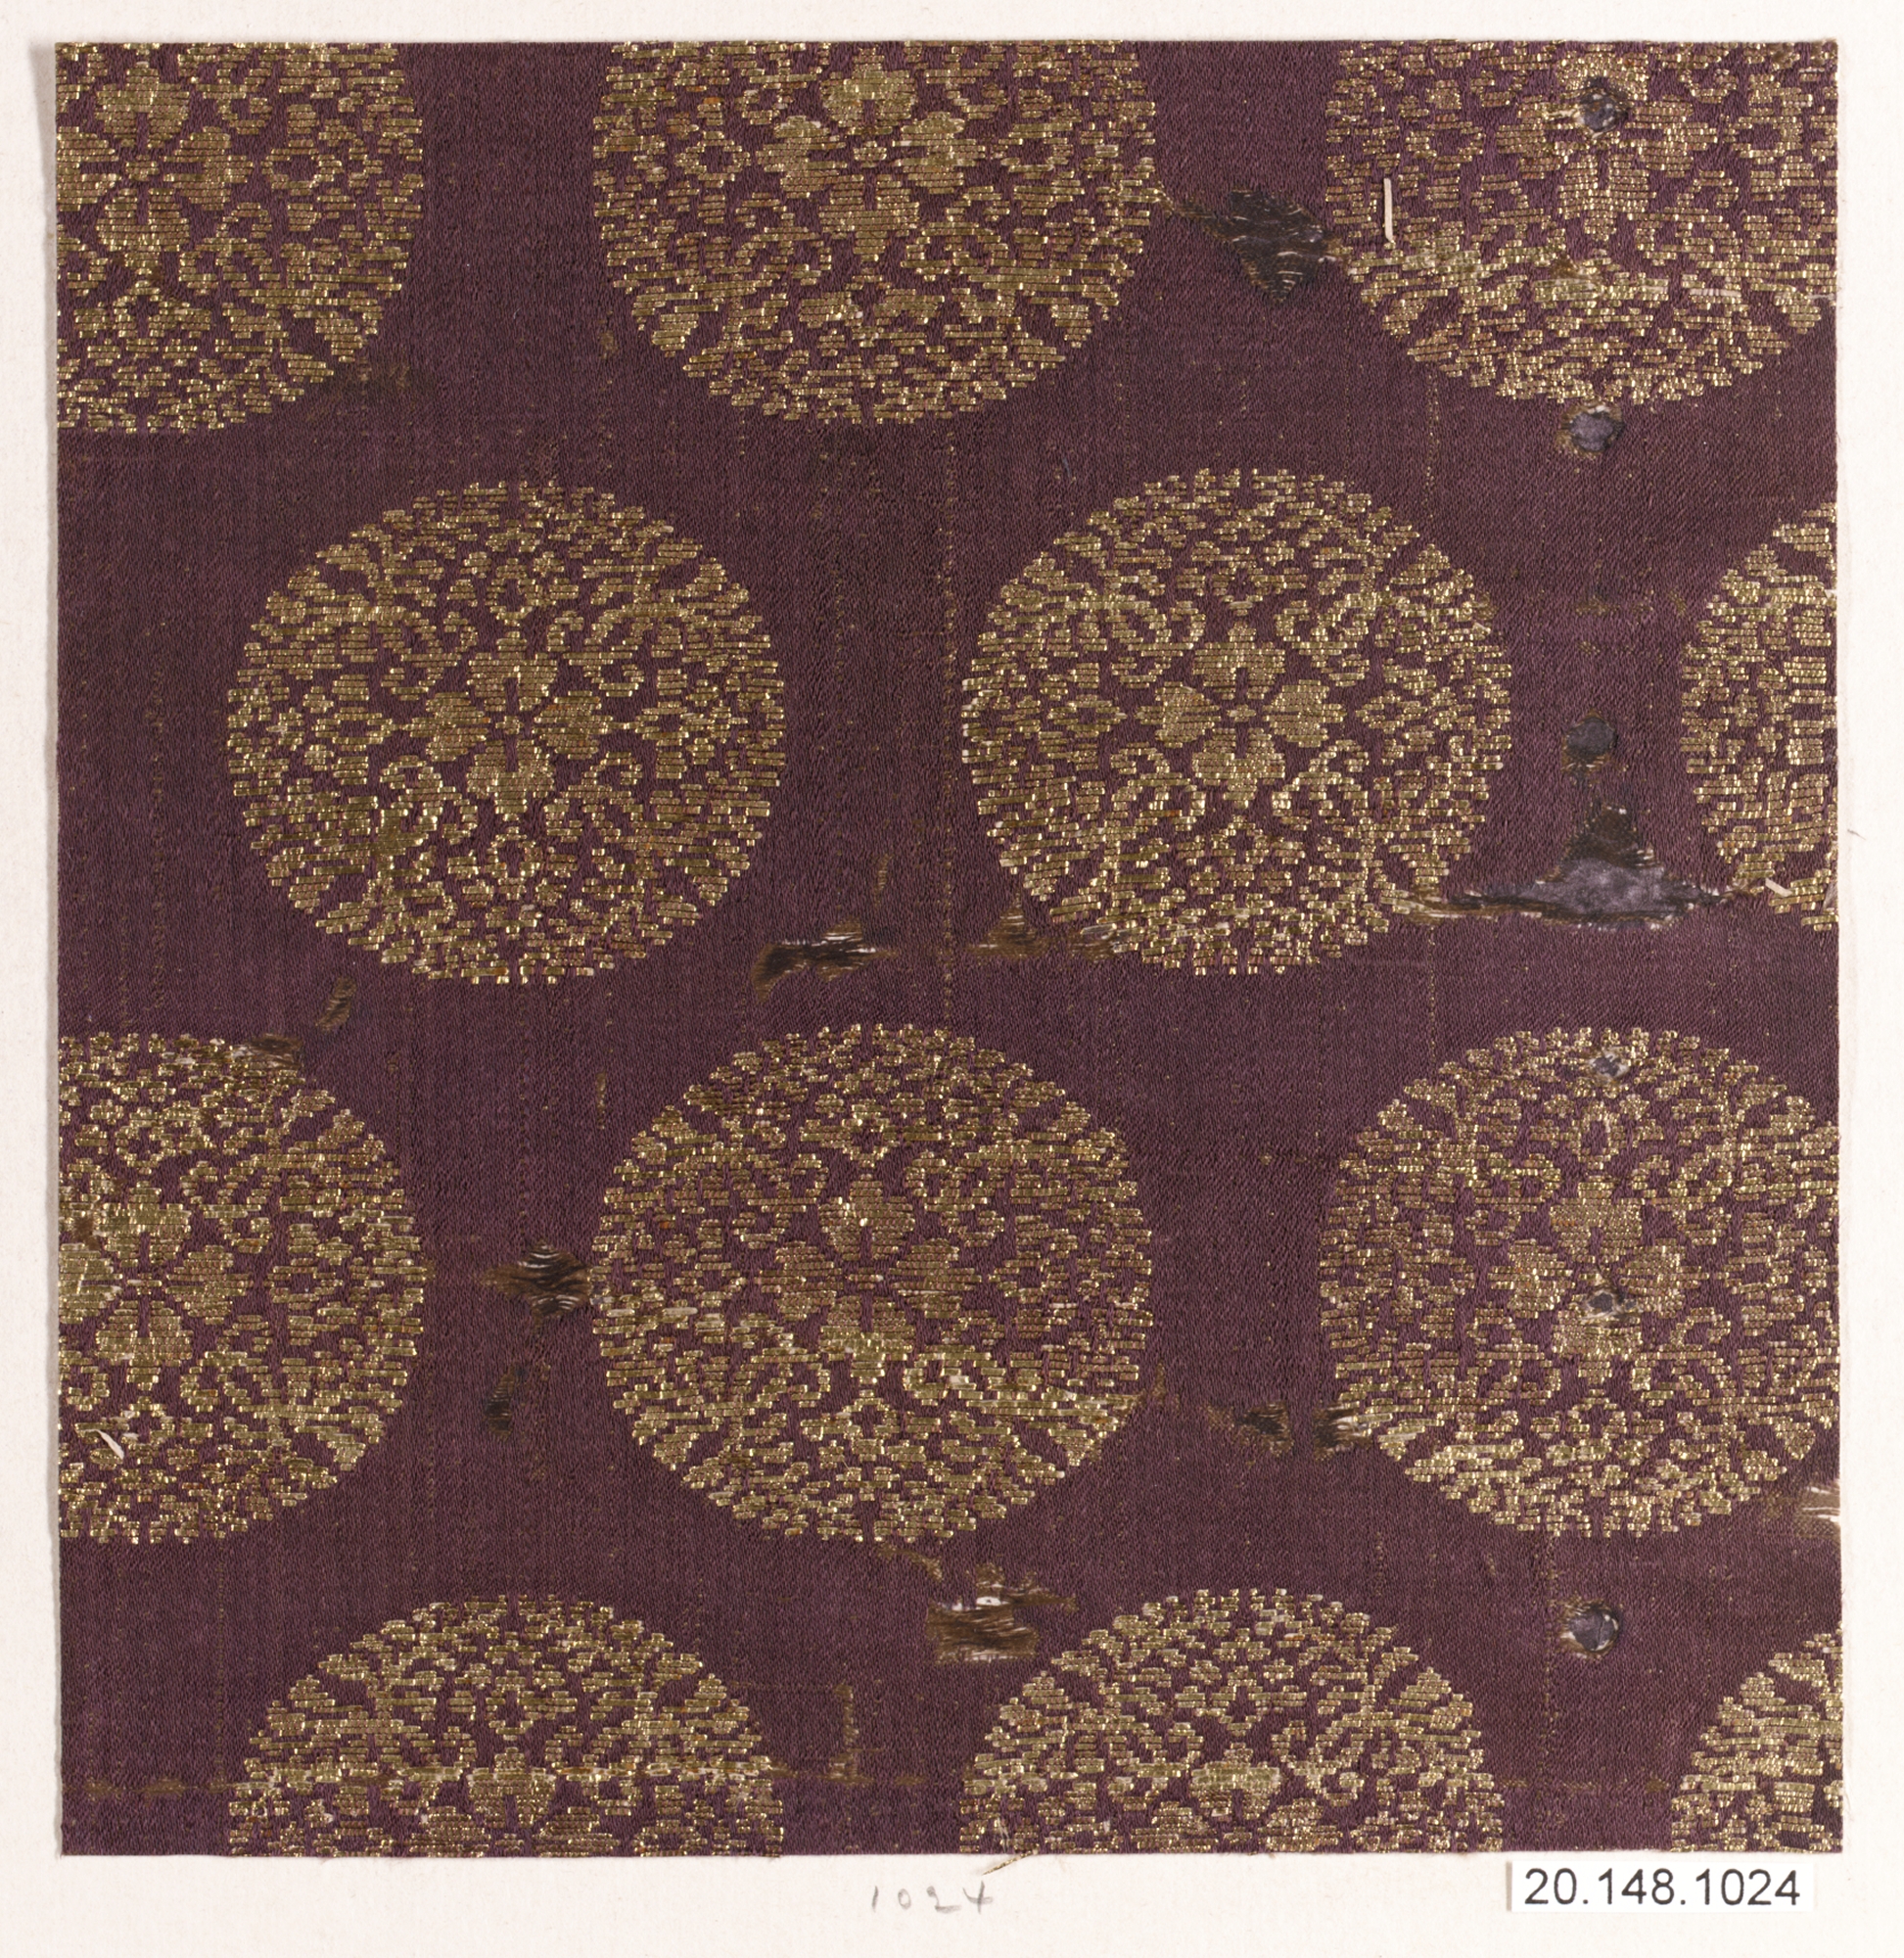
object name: piece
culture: japanese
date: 1501-1600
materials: silk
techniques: compound weave